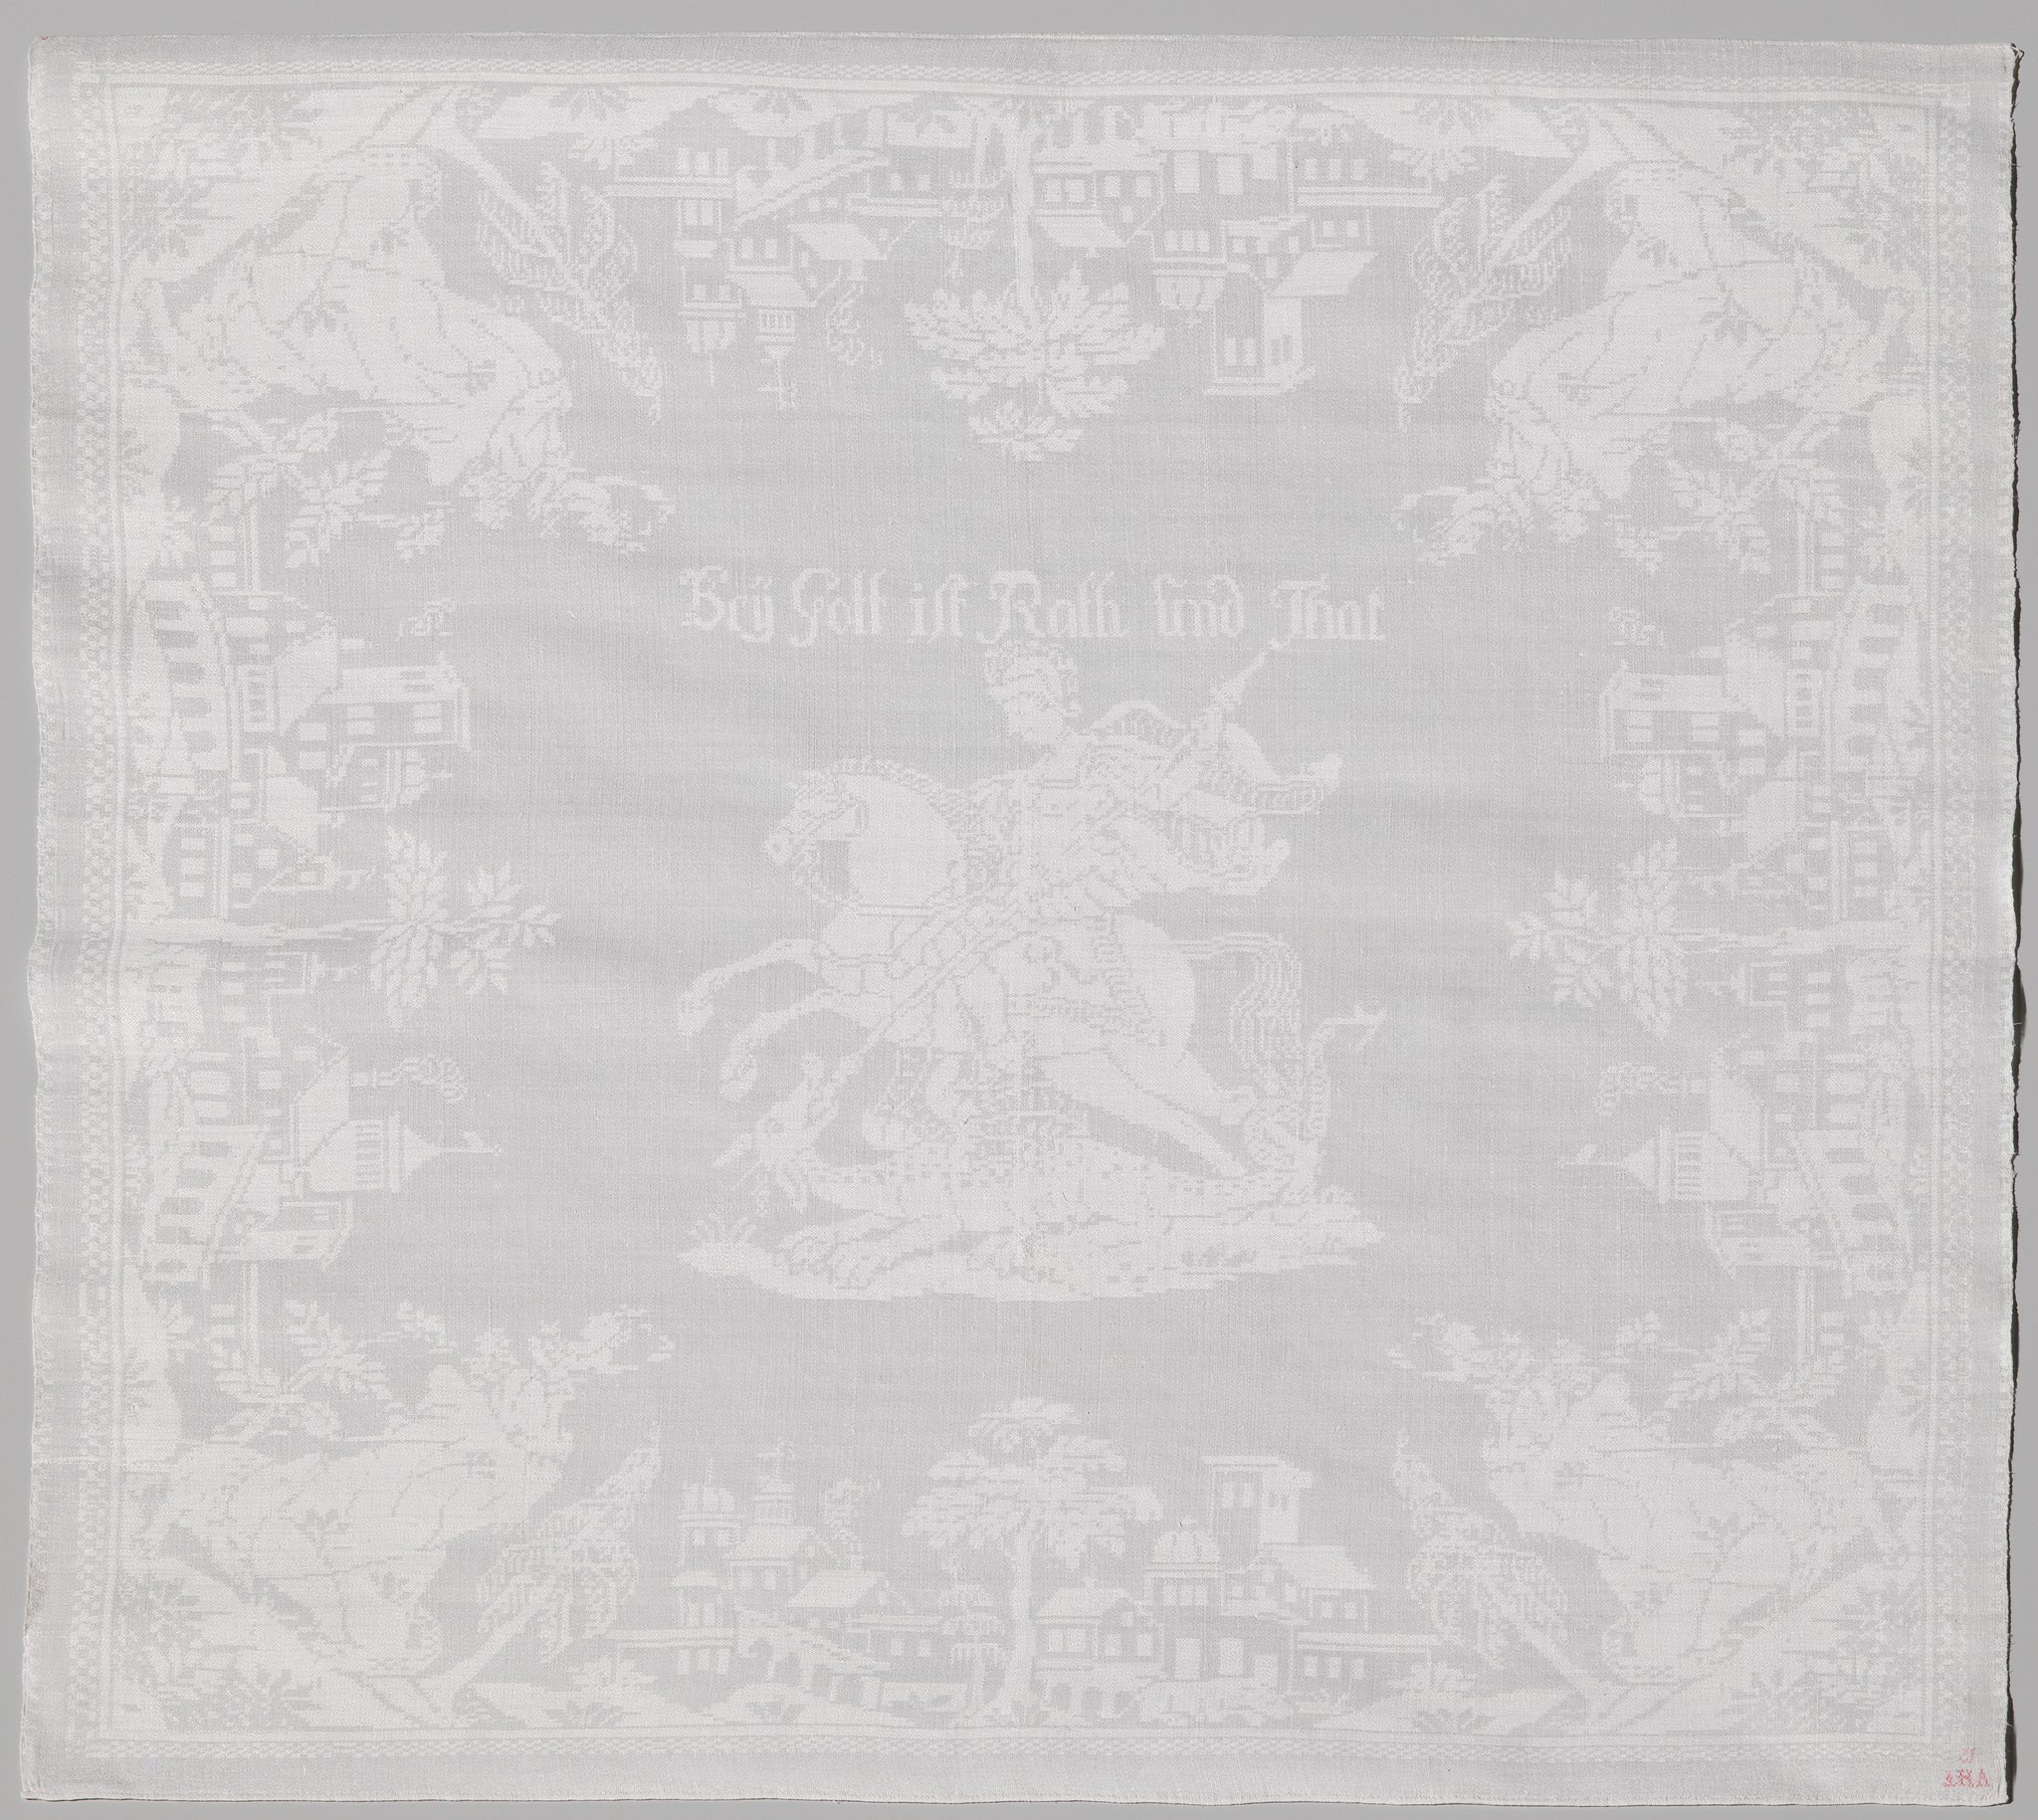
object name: napkin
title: Servet met St. Joris en de draak; randen met stadsgezichten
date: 1740-1760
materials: linen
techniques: damask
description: Wit linnen damasten servet met St. Joris en de Draak en de randen met stadsgezichten. Inweving van de tekst "Beij Gott ist Rath und That". gemerkt met rode kruissteek VHT 12.